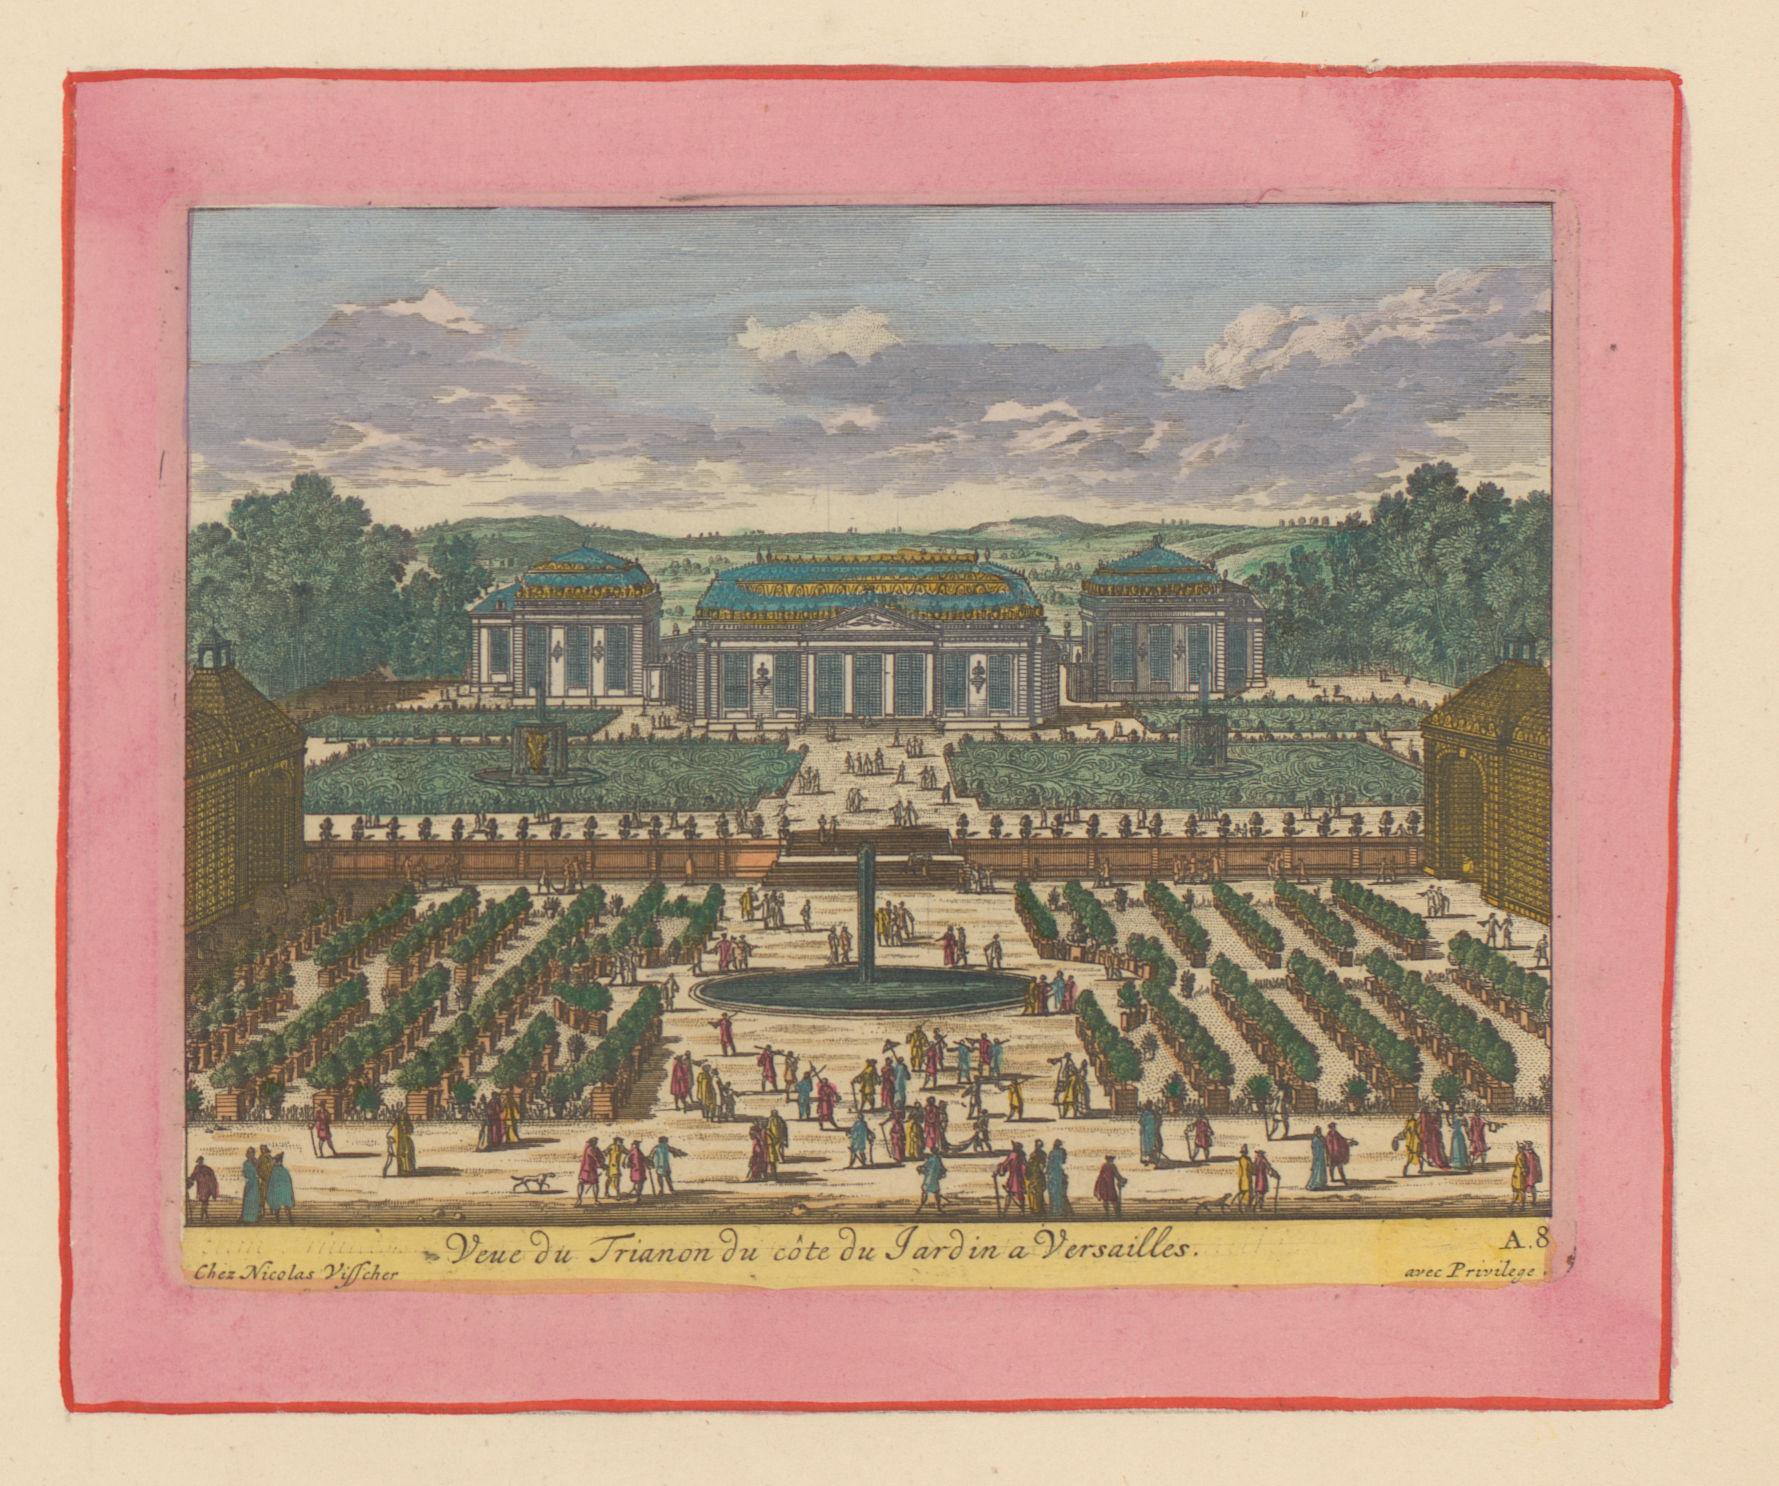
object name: print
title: Veue du Trianon du côte du Jardin a Versailles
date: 1686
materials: paper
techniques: etching, hand coloring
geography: amsterdam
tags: palace, french or architectonic garden; formal garden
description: De prent maakt deel uit van een serie bestaande uit 87 genummerde prenten (volgens Hollstein). De serie is opgedeeld in de delen A t/m F.